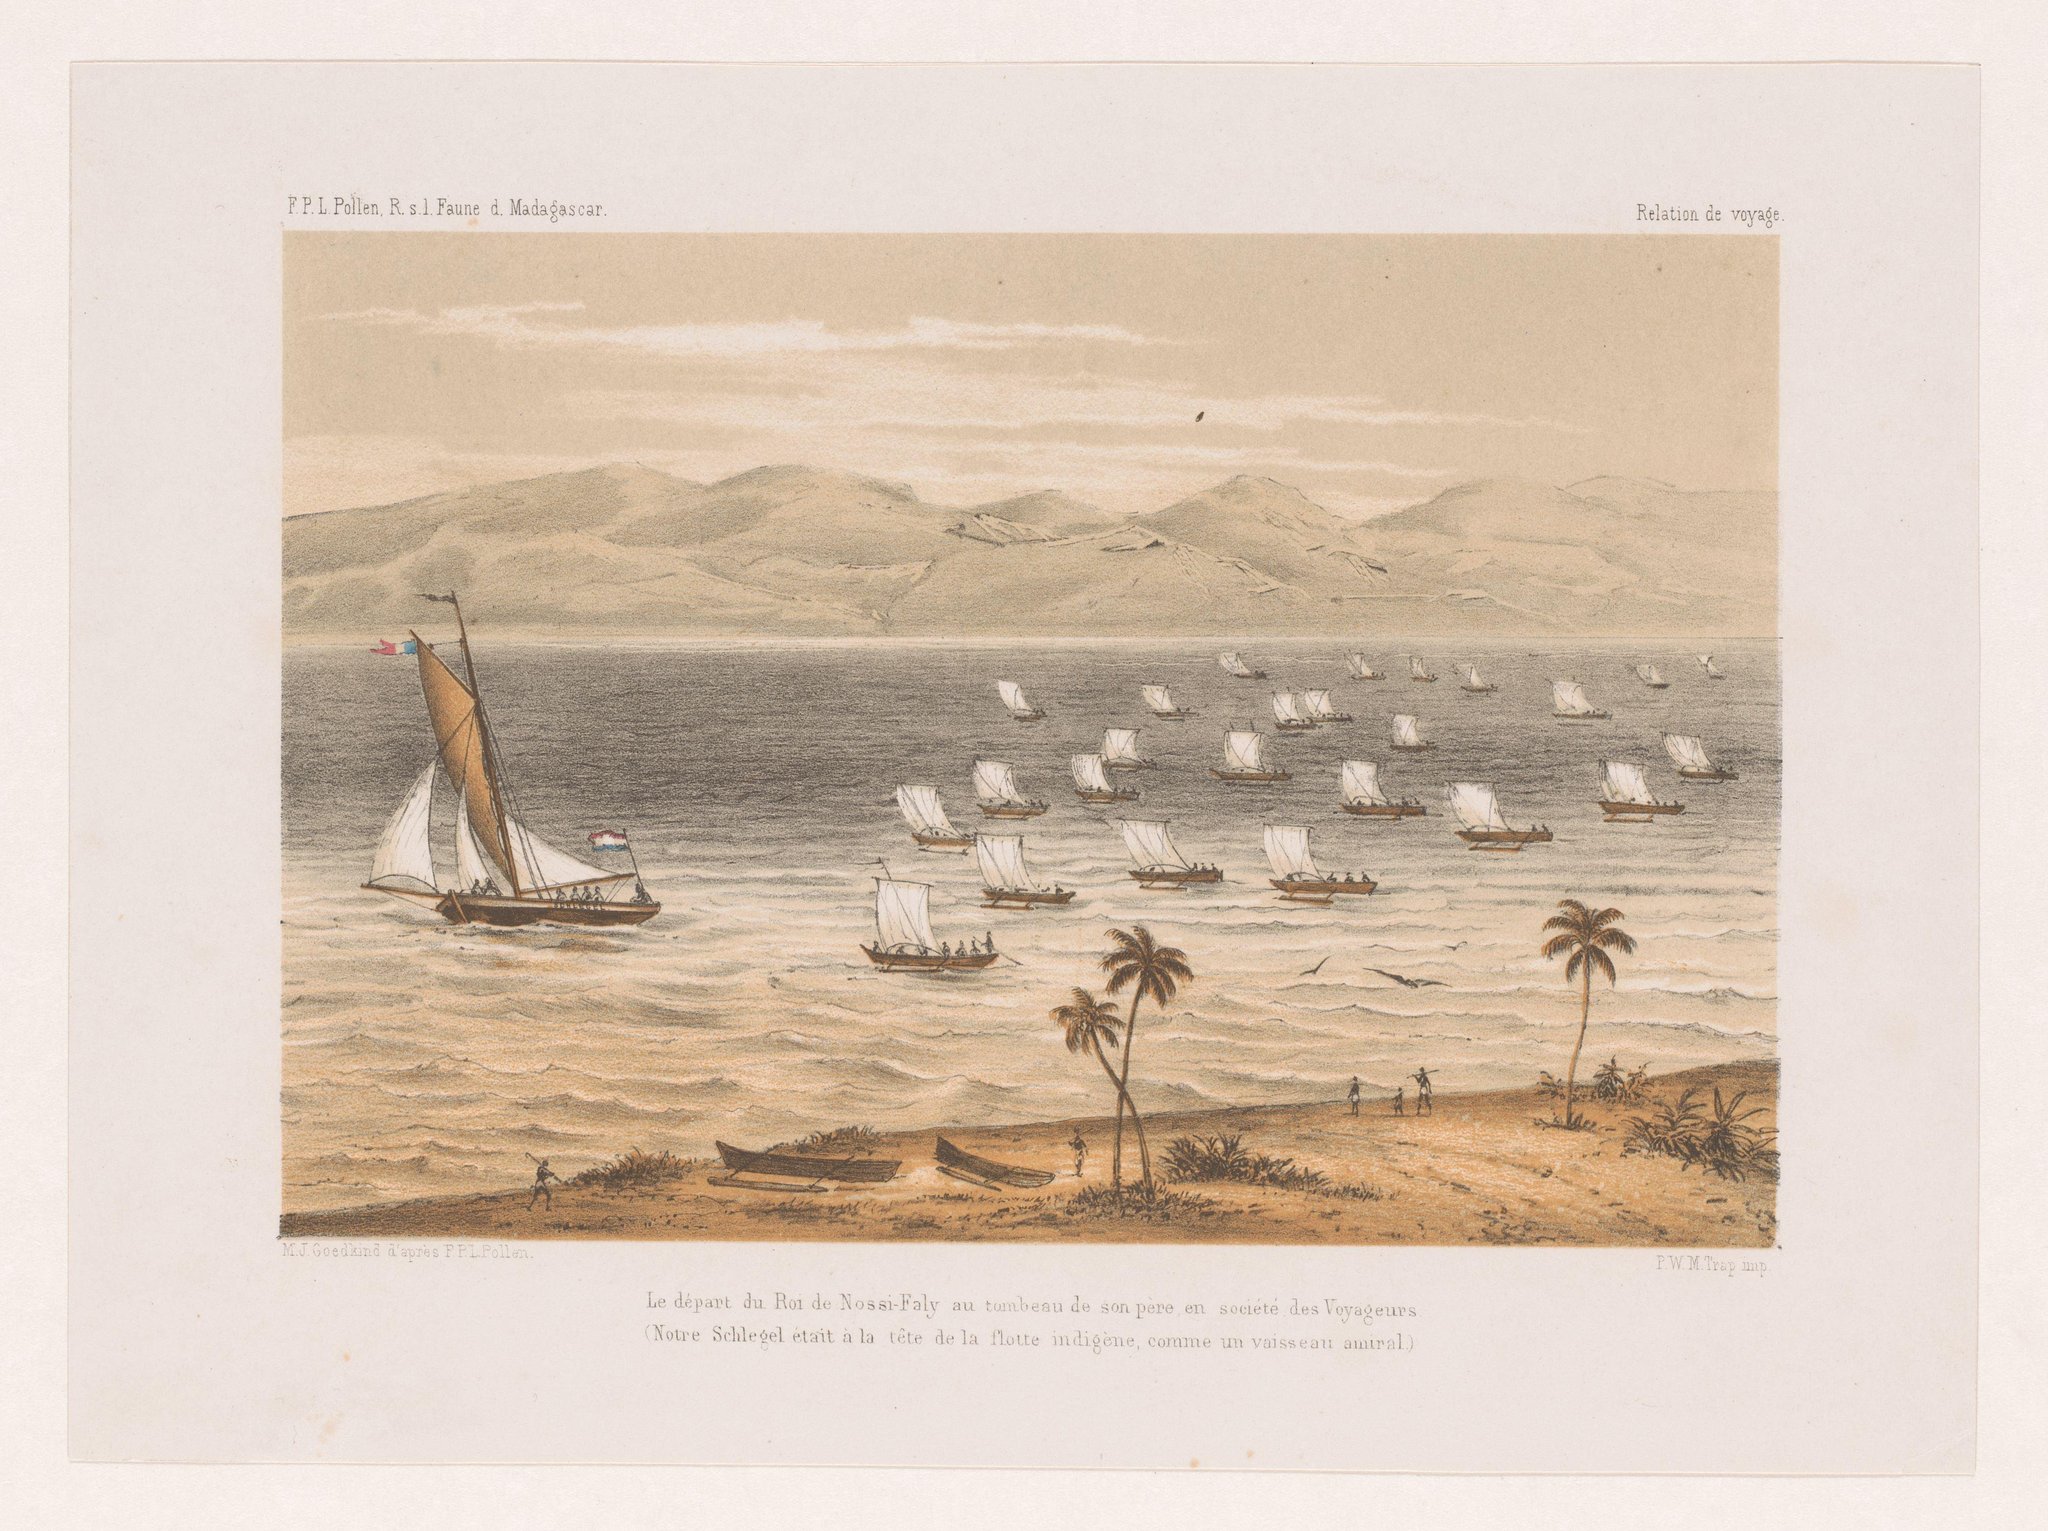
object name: print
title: Reis van François P.L. Pollen naar Madagaskar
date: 1868-1877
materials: paper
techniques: hand coloring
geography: amsterdam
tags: sailing-ship, sailing-boat, navy (+ sailing-ships)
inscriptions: collector's mark: Lugt 2228, collector's mark: Lugt 2760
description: François P.L. Pollen reisde tussen 1863 en 1866 naar Madagascar. Hij verzamelde insecten, vogels, vissen en zoogdieren voor het Rijksmuseum van Natuurlijke Historie in Leiden en deed onderzoek. Deze prent maakte deel uit van: Pollen, F. P. L. Recherches sur la faune de Madagascar et de ses dépendances, d'après les découvertes de François P. L. Pollen et D. C. Van Dam. Leiden: J. K. Steenhoff, 1868-1877.